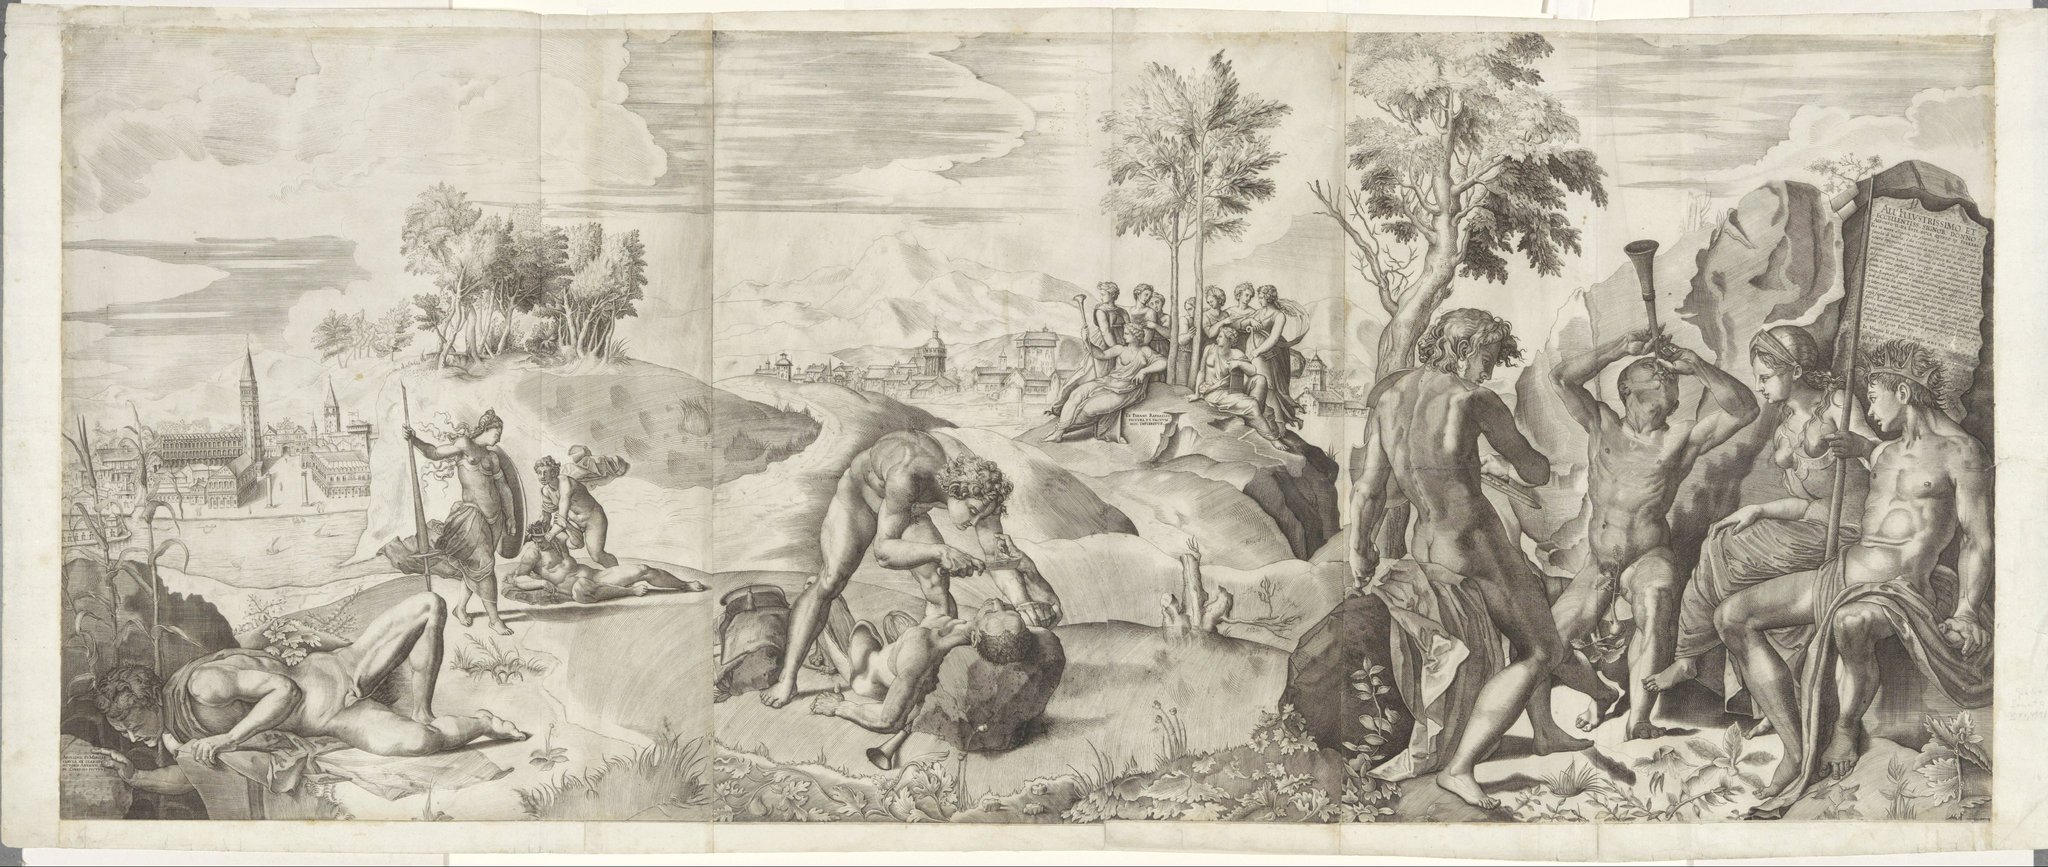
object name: album leaf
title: Apollo en Marsyas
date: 1562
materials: paper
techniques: engraving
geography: rome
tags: the muses acting together (as group) - attributes, punishment of marsyas: he is flayed by apollo, contest between apollo and marsyas; the muses acting as judges, (story of) midas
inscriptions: watermark, watermark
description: Folio 21 uit het prentalbum van Johann Georg I. Zobel von Giebelstadt (Röttingen 1543-07-20 - Bamberg 1580-09-07), de latere bisschop van Bamberg. Het album is vermoedelijk samengesteld tussen 1568 en 1570 in Venetië. Het album werd in 1999 uit elkaar genomen door een antiquair. De in totaal 124 folio's met prenten uit het "Zobel Album" werden aangekocht door verschillende musea en privéverzamelingen. De grootste groep (68 folio's) bevindt zich in de collectie van het Rijksmuseum. Verschillende elementen uit de muziekwedstrijd tussen Apollo en Marsyas en de wedstrijd tussen Apollo en Pan zijn hier door elkaar gehaald. Oorspronkelijk speelden Apollo en Marsyas voor de muzen. In de tweede ronde waar ze moesten spelen en zingen tegelijk verloor Marsyas omdat hij fluit speelt en daarbij niet kan zingen. Deze mix komt veel vaker voor. Naar een schilderij van Bronzino (Leningrad, Hermitage, inv. nr.: 250). Dit schilderij is door Sanuto op de prent verkeerd toegeschreven aan Correggio. Twee getekende voorstudies door Bronzino worden bewaard in het Louvre (inv. nr.: 5923r-v). Het detail van Apollo die Marsyas vilt kopieerde Bronzino naar een schilderij van Pontormo (Florence, Galleria degli Uffizi, inv. nr.: 1525). Het detail van de schreeuwende kapper kopieerde Bronzino naar een tekening van Pontormo 'Drinkende Isrealiten' (Londen, British Museum, inv. nr.: 1946,0713.380). Het detail van de Muzen kopieerde Sanuto naar een prent van Marcantonio Raimondi (Londen, British Museum, inv. nr.: 1910,0212.335). Raimondi kopieerde deze voorstelling naar een fresco van Rafaël in de Stanza della Segnatura (Stanze di Raffaello) in het Apostolisch paleis, onderdeel van de Vaticaanse Musea.